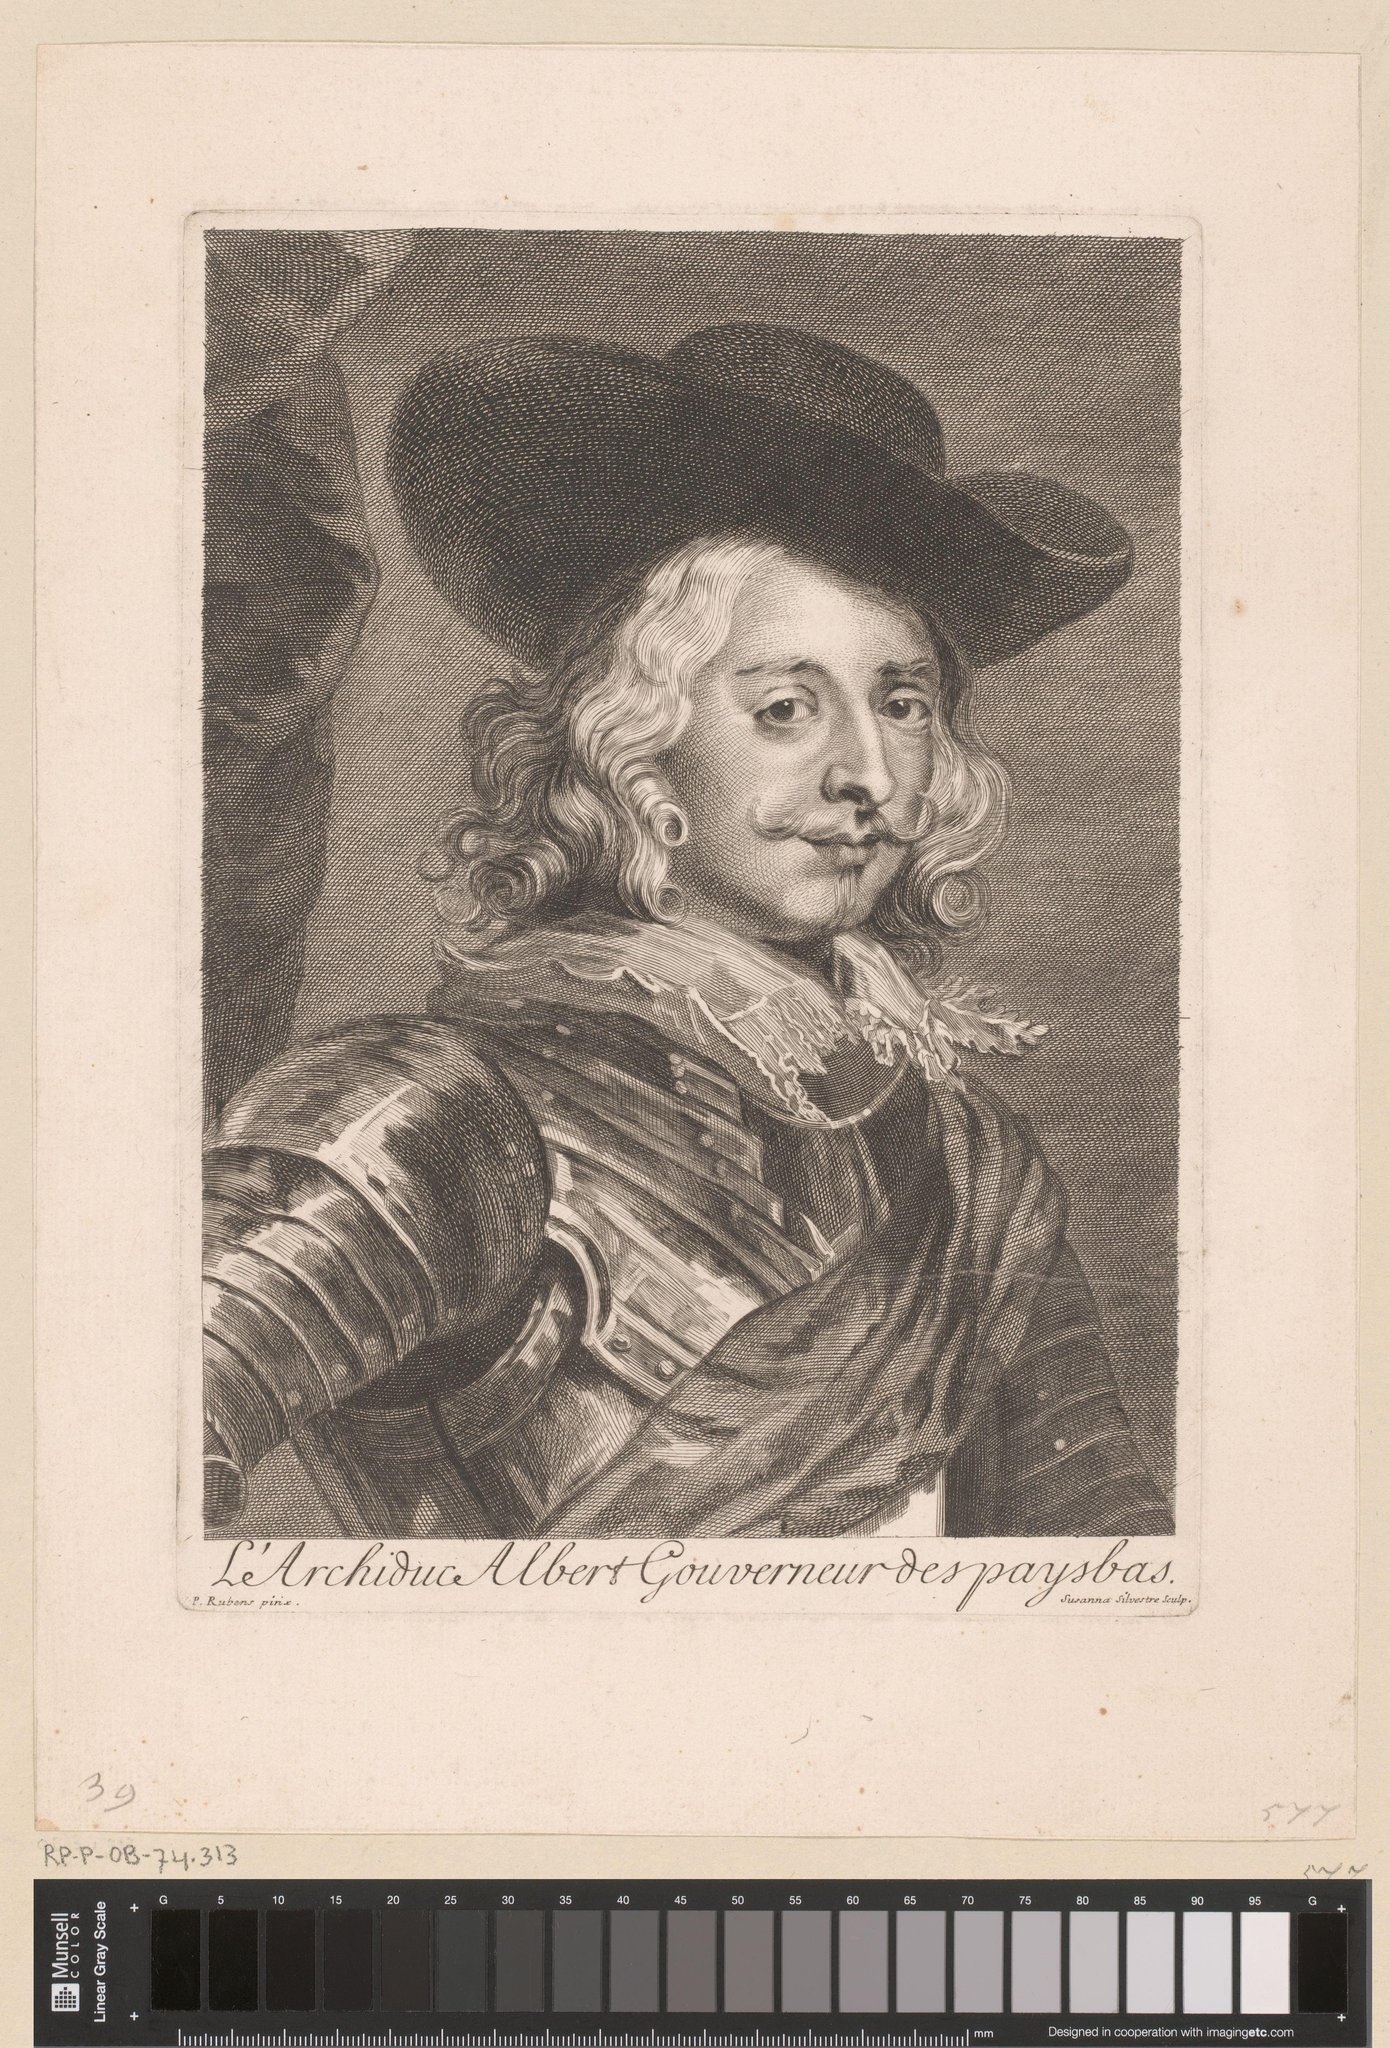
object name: print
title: Portret van Ferdinand van Oostenrijk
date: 1704-1738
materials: paper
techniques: engraving, etching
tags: brussels, landvoogd der zuidelijke nederlanden ferdinand van oostenrijk, historical persons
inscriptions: collector's mark: Lugt 240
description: In het onderschrift foutief geïdentificeerd als Albert VII.